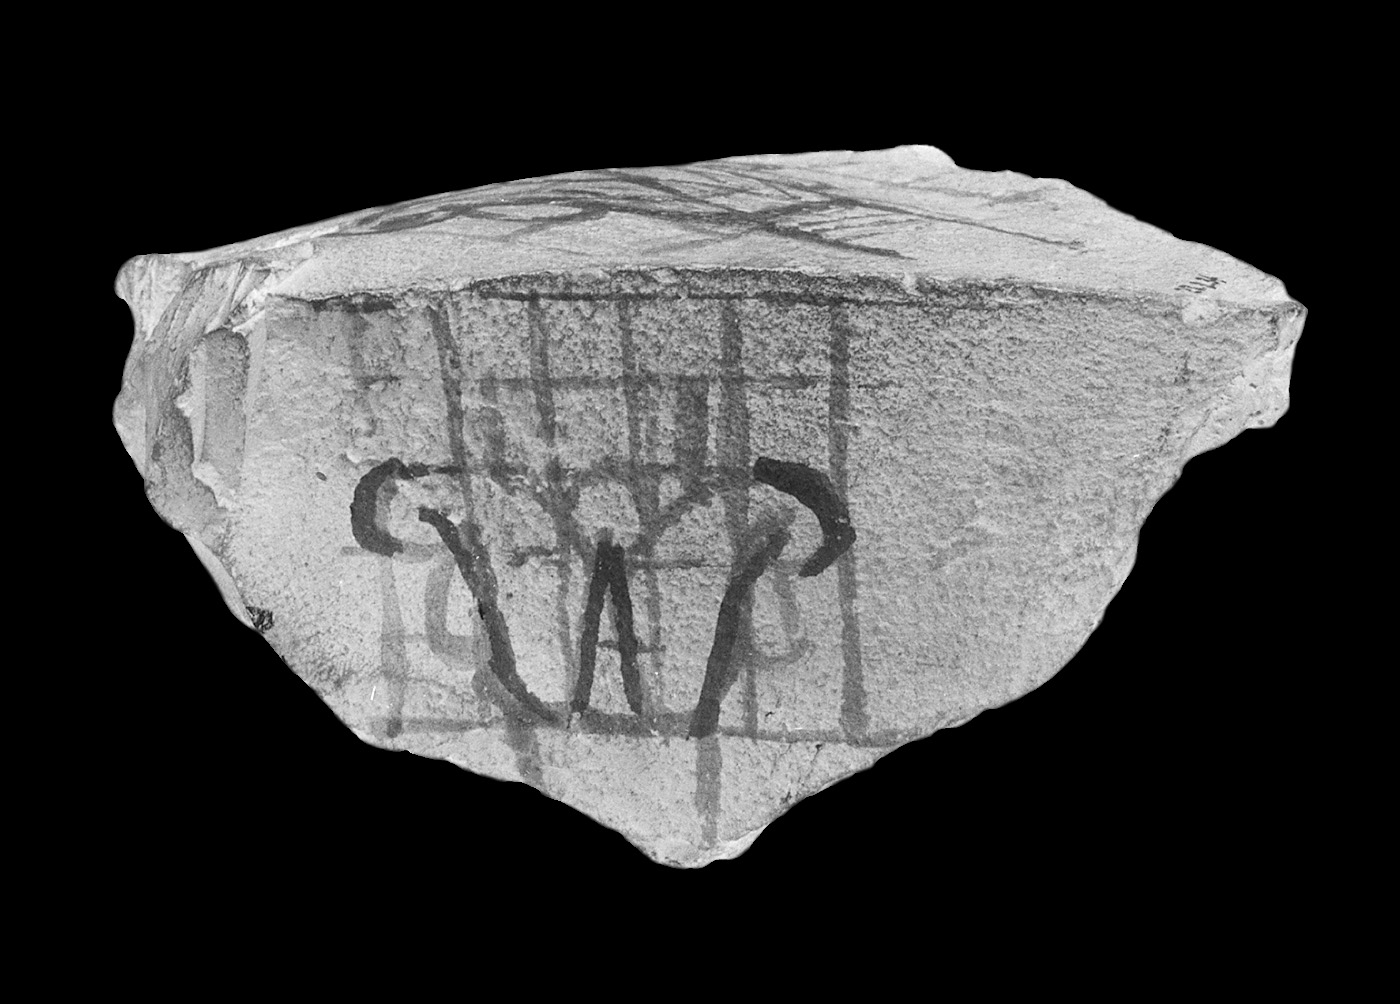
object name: ostracon, figured, lotus capital, grid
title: Ostracon with liliform capital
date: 664-610 BCE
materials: ink, limestone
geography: egypt